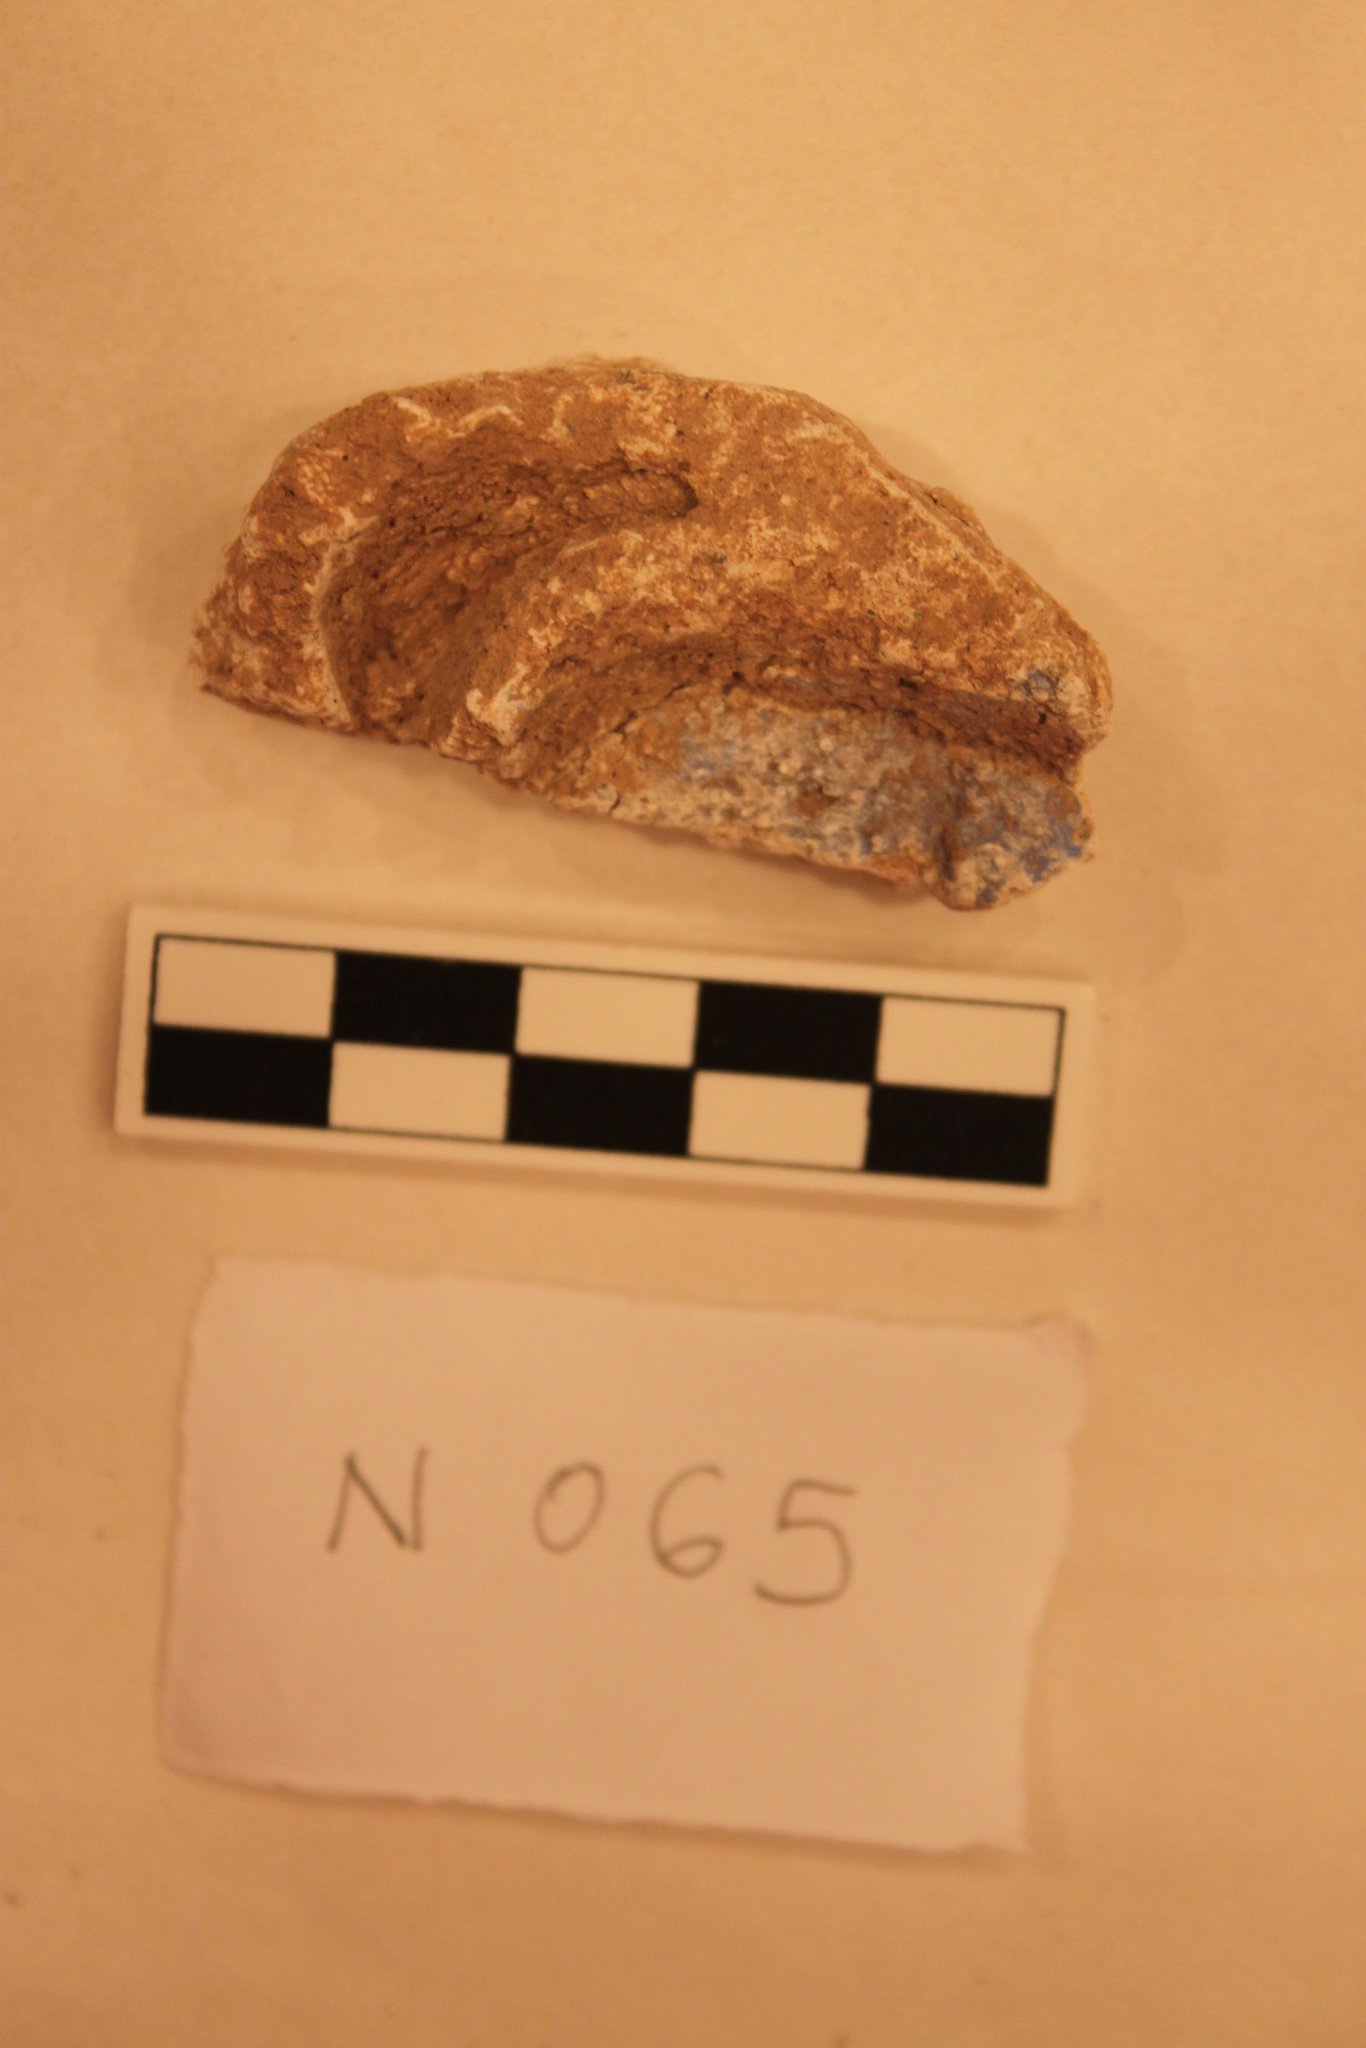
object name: fragment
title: Stucco Fragment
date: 701-1200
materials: plaster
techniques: carving, painting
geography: iran